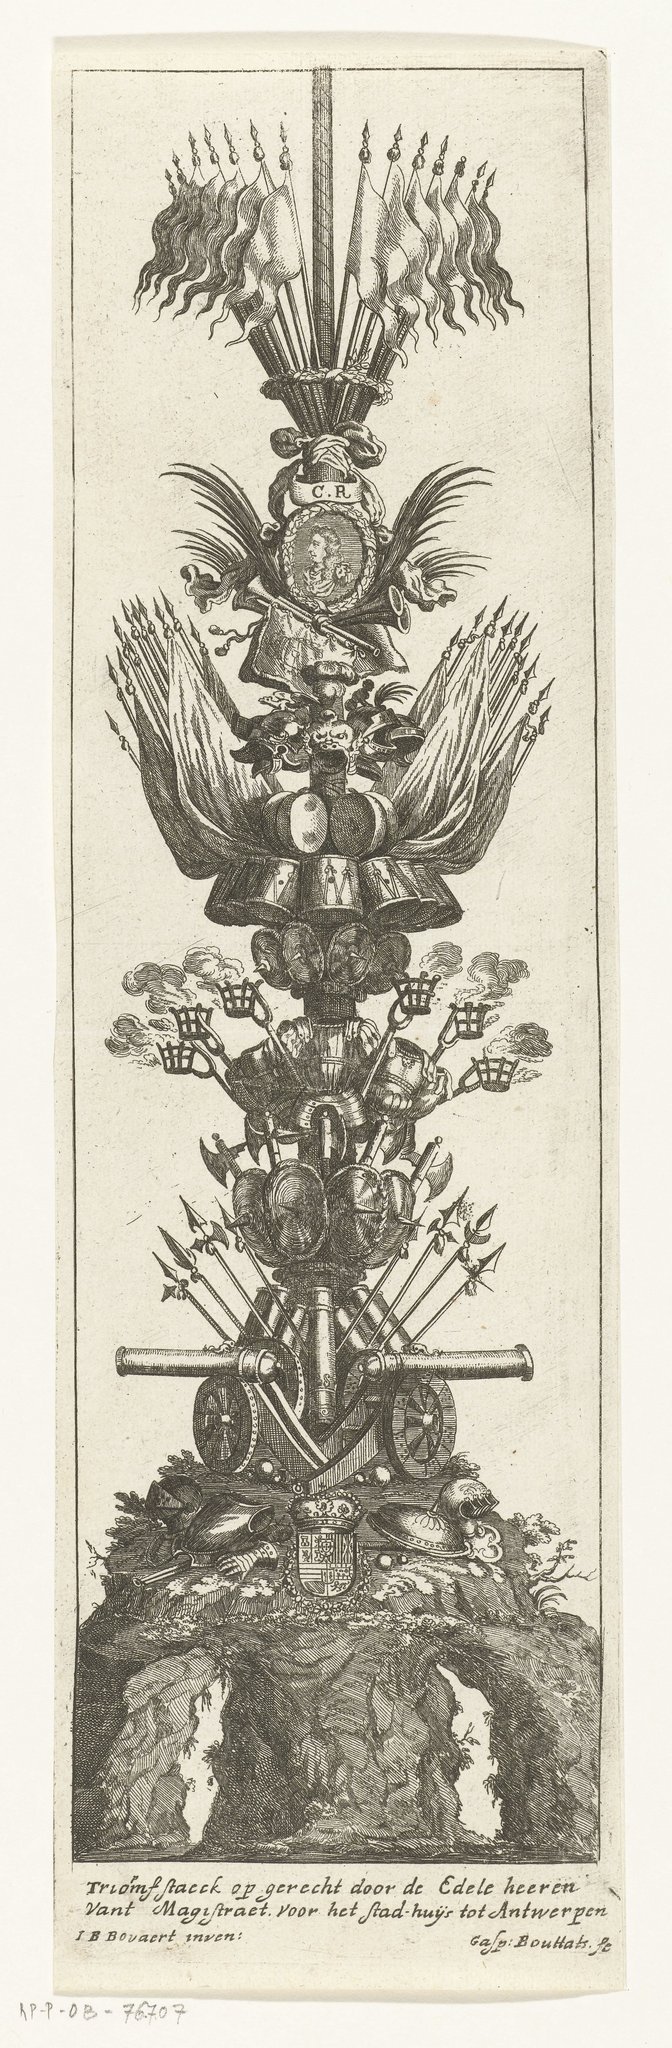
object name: print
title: Triomf staeck op gerecht door de Edele heeren Vant Magistraet Voor het stad-huys tot Antwerpen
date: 1685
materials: paper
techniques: etching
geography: southern netherlands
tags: other decorative structures (~ triumphal entry, etc.), antwerp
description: Gebruikt als illustratie in: Hondert-jaerigh jubile-vreught bewesen in dese stadt Antwerpen ter oorsaecke vande herstellinge des geloofs in't jaer 1585. door de glorieuse waepenen van sijne catholijcke majesteyt, onder t'beleyt van ... Alexander Farnesius ... / Ghemaeckt ende by-een vergadert door ... Petrus Franciscus de Smidt, Hieronymus Verdussen den jonghere, Antwerpen 1685.